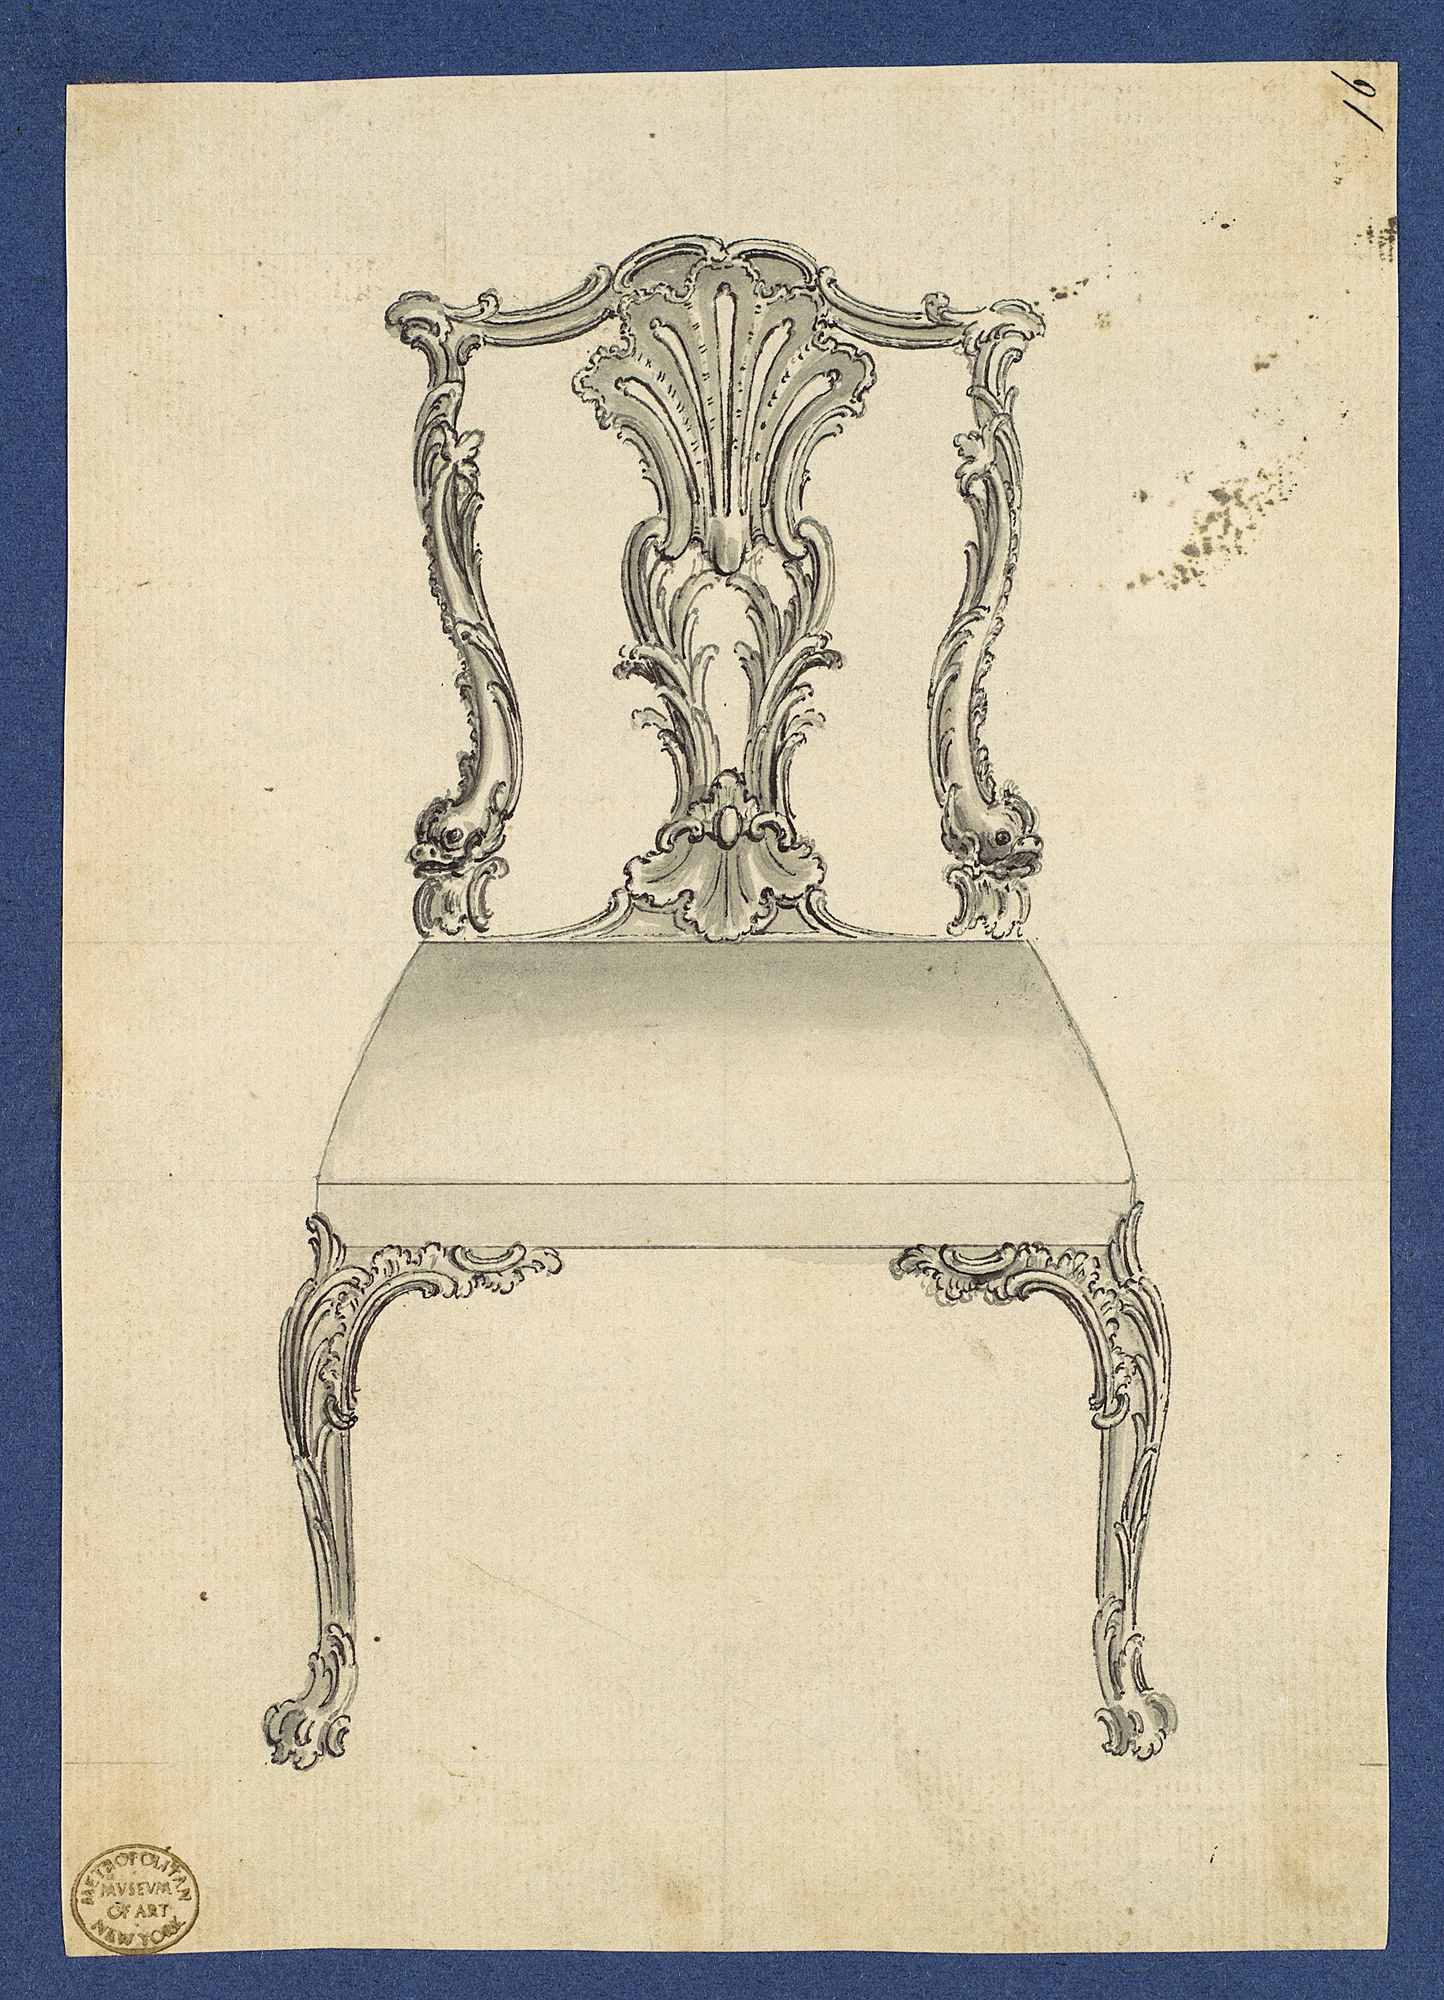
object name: drawing ornament architecture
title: Chair, in Chippendale Drawings, Vol. I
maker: thomas chippendale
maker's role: artist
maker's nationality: british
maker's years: 1718-1779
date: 1761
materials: ink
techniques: wash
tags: chairs